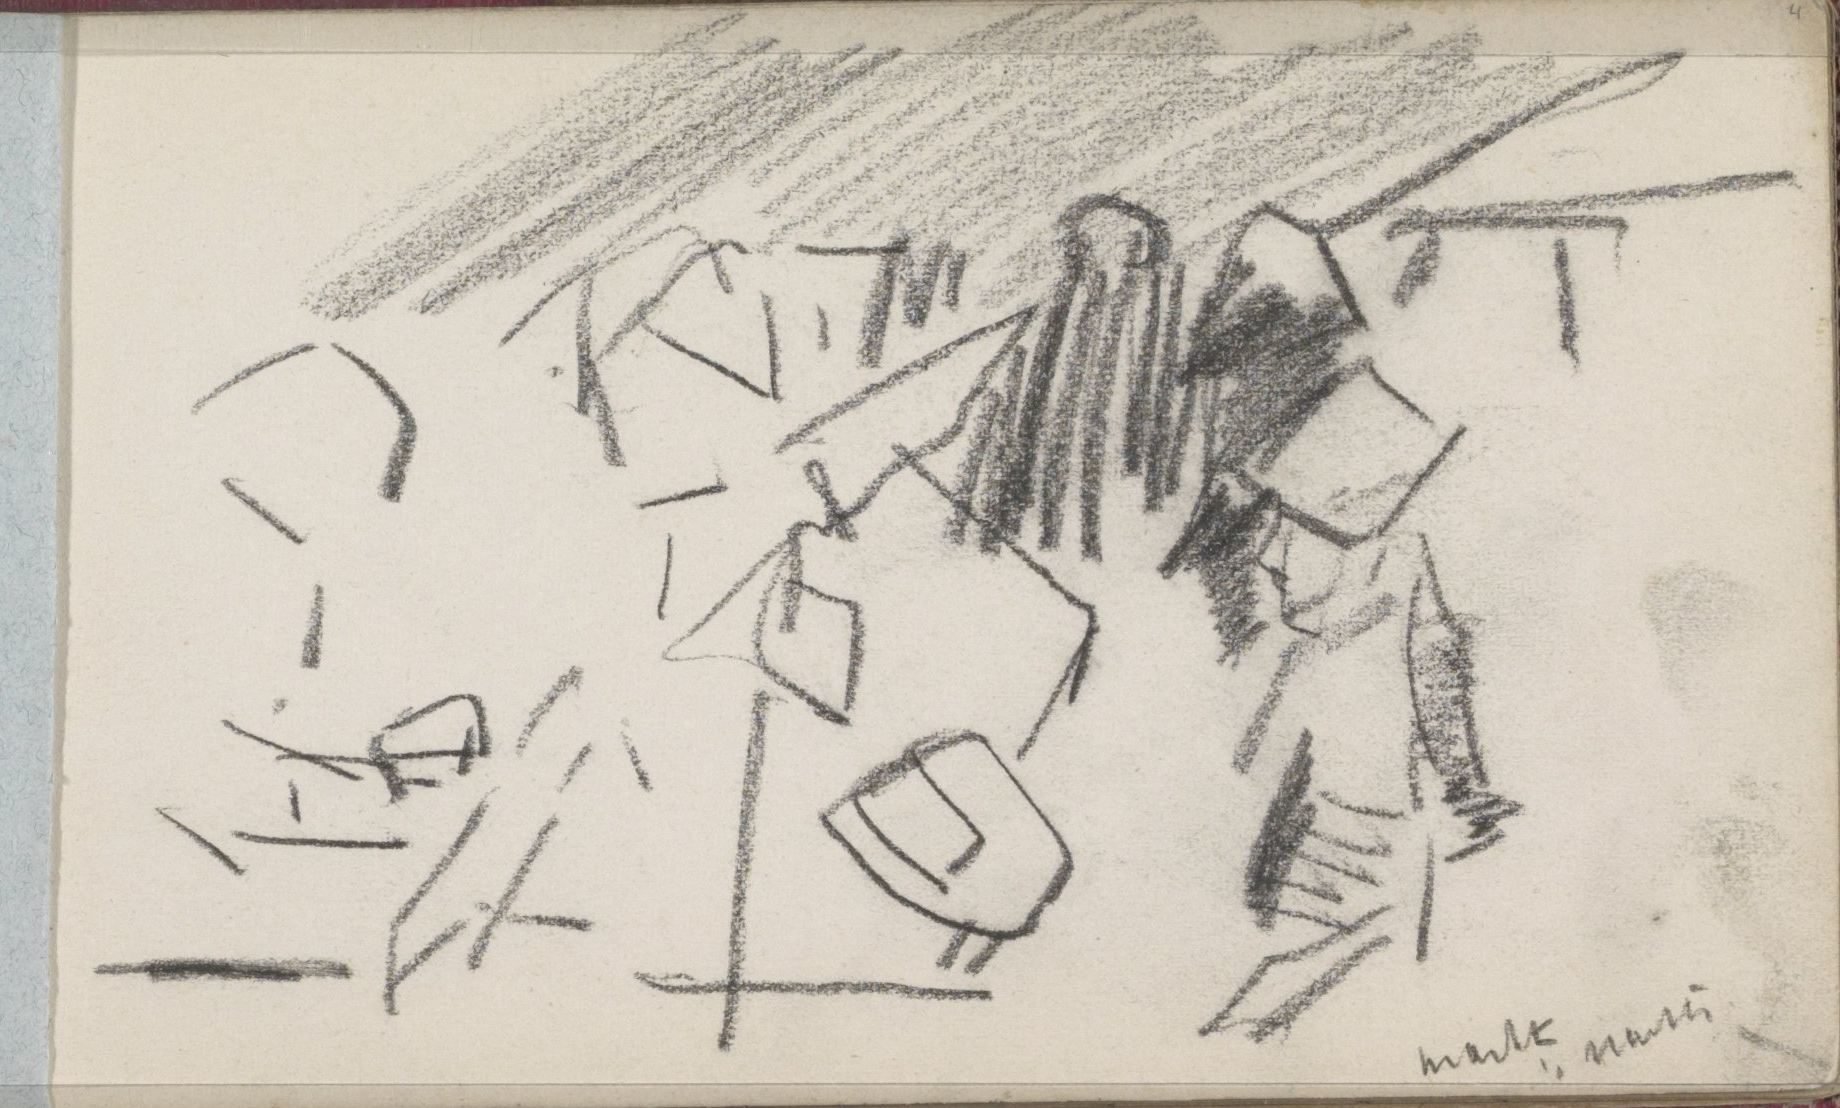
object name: sketchbook leaf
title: Gezicht op een markt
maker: george hendrik breitner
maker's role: draughtsman, painter, print maker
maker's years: 1857-1923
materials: chalk, paper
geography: amsterdam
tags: market, amsterdam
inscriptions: annotation: ‘markt/ 's nachts’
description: Pagina 4 uit een schetsboek met 32 bladen.